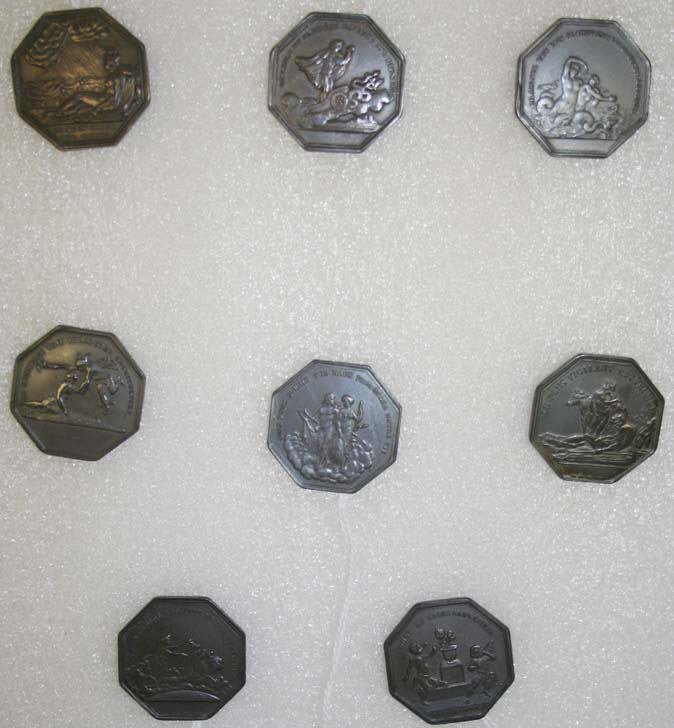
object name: button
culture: french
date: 1880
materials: metal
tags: human figures